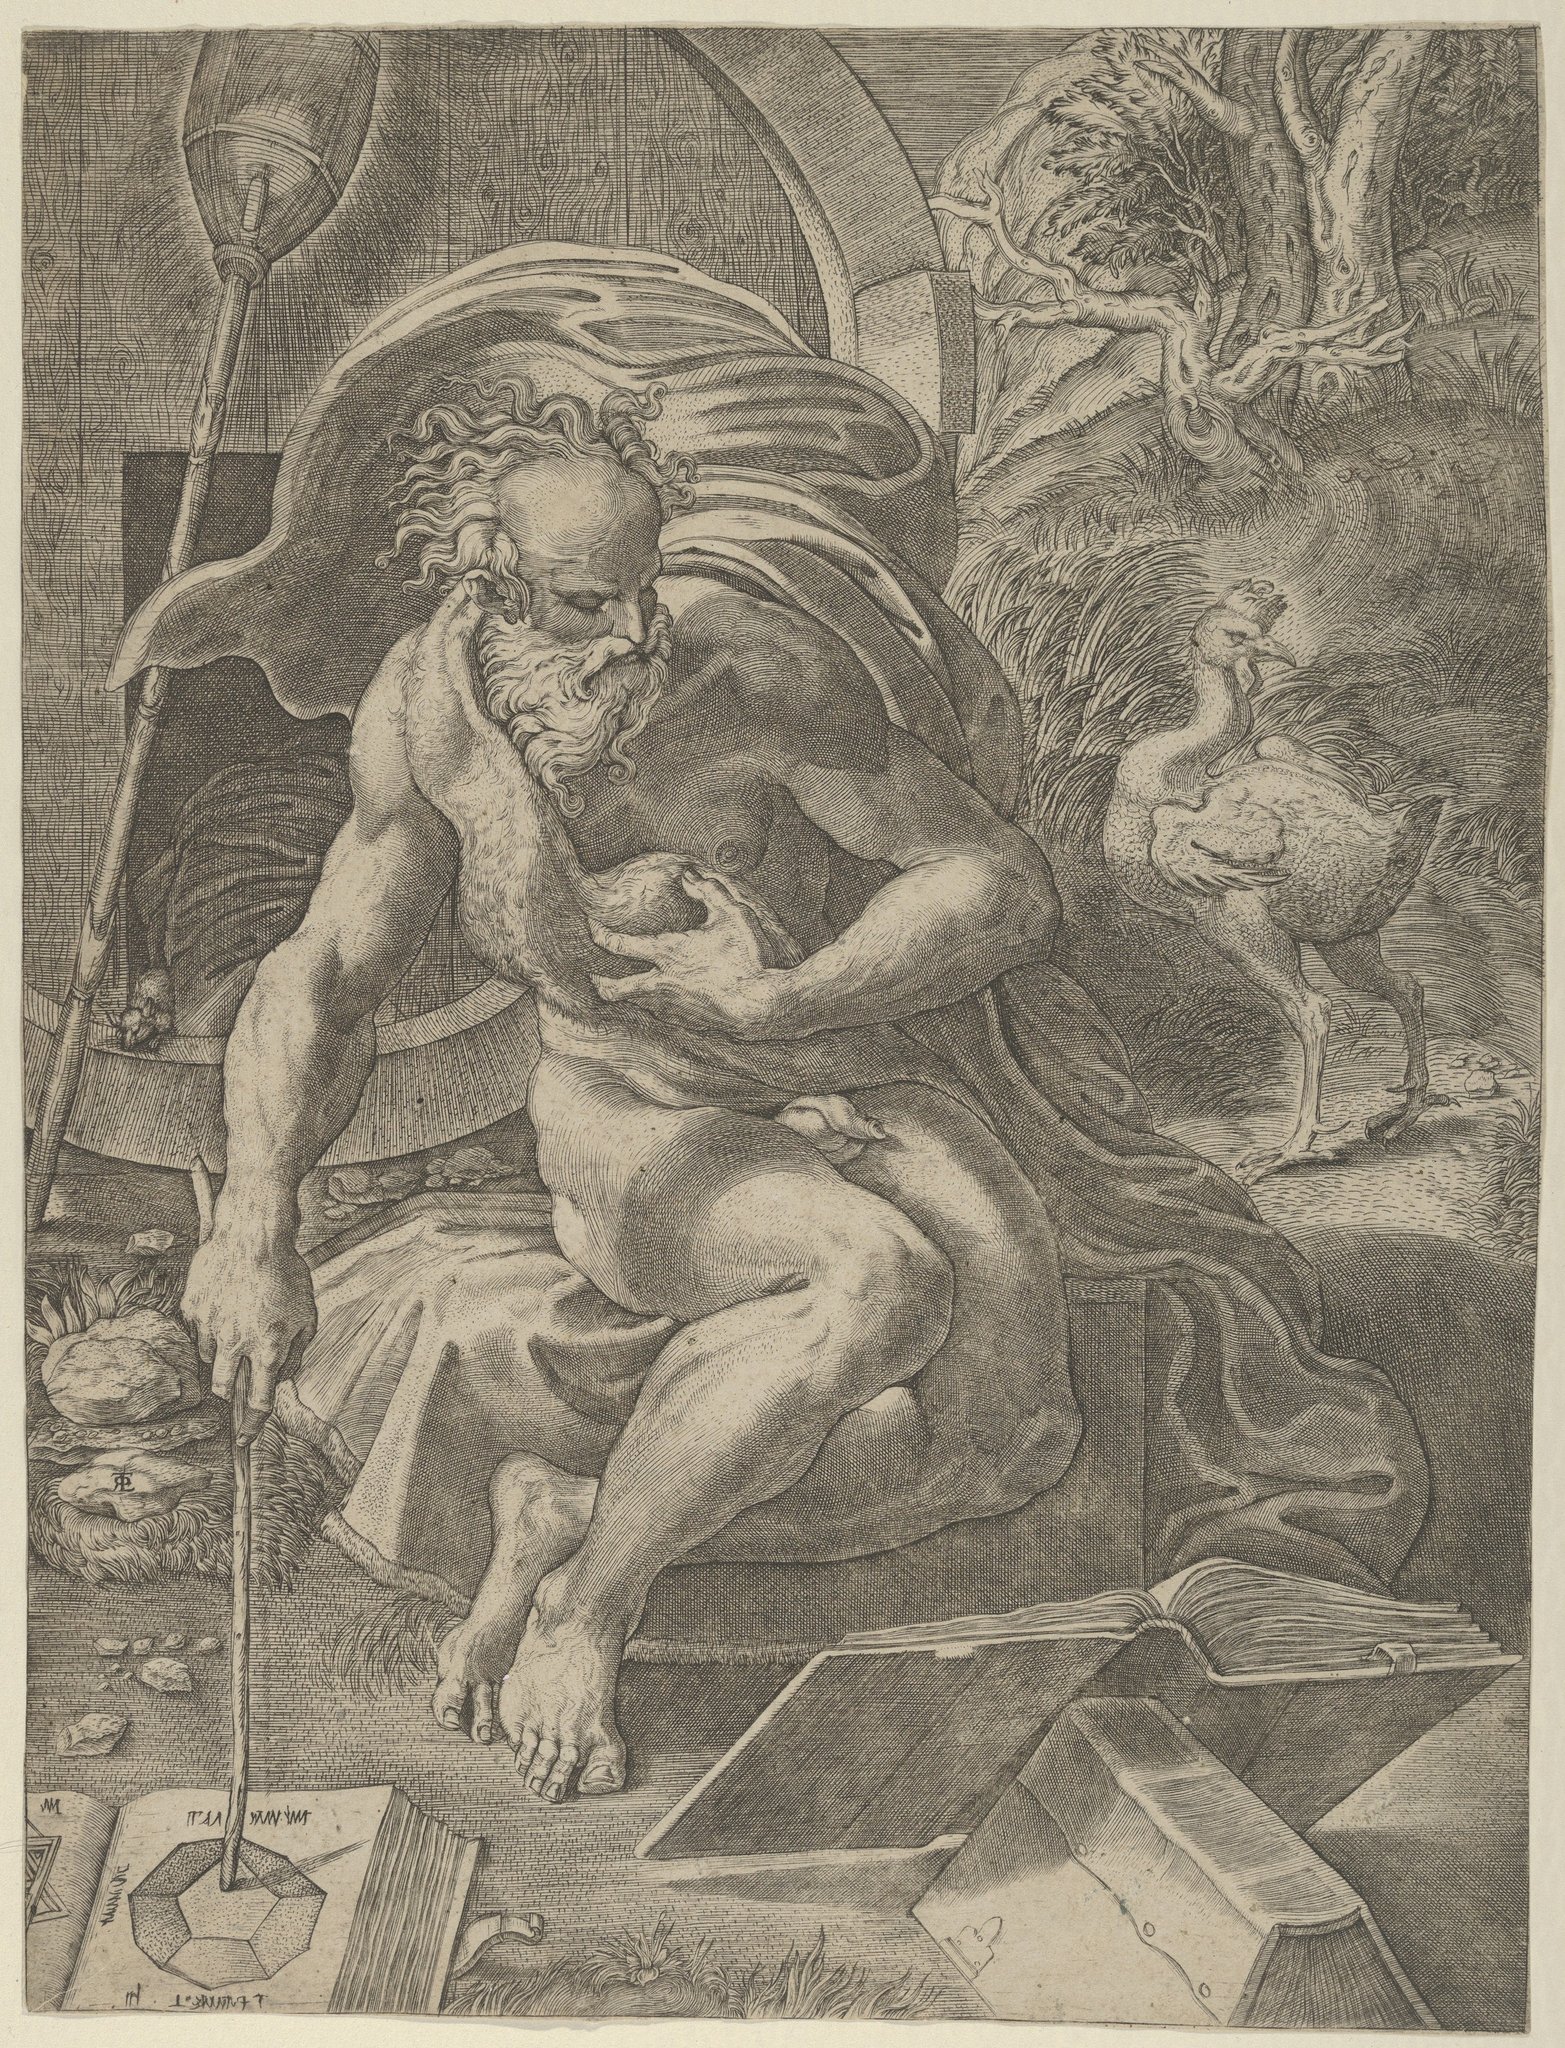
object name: print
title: Diogenes seated with his barrel behind him, and reading a book while holding a stick that rests on a geometry book to his right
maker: giovanni jacopo caraglio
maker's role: artist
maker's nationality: italian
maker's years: 1500-1565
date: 1526-1527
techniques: engraving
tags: birds,diogenes,men